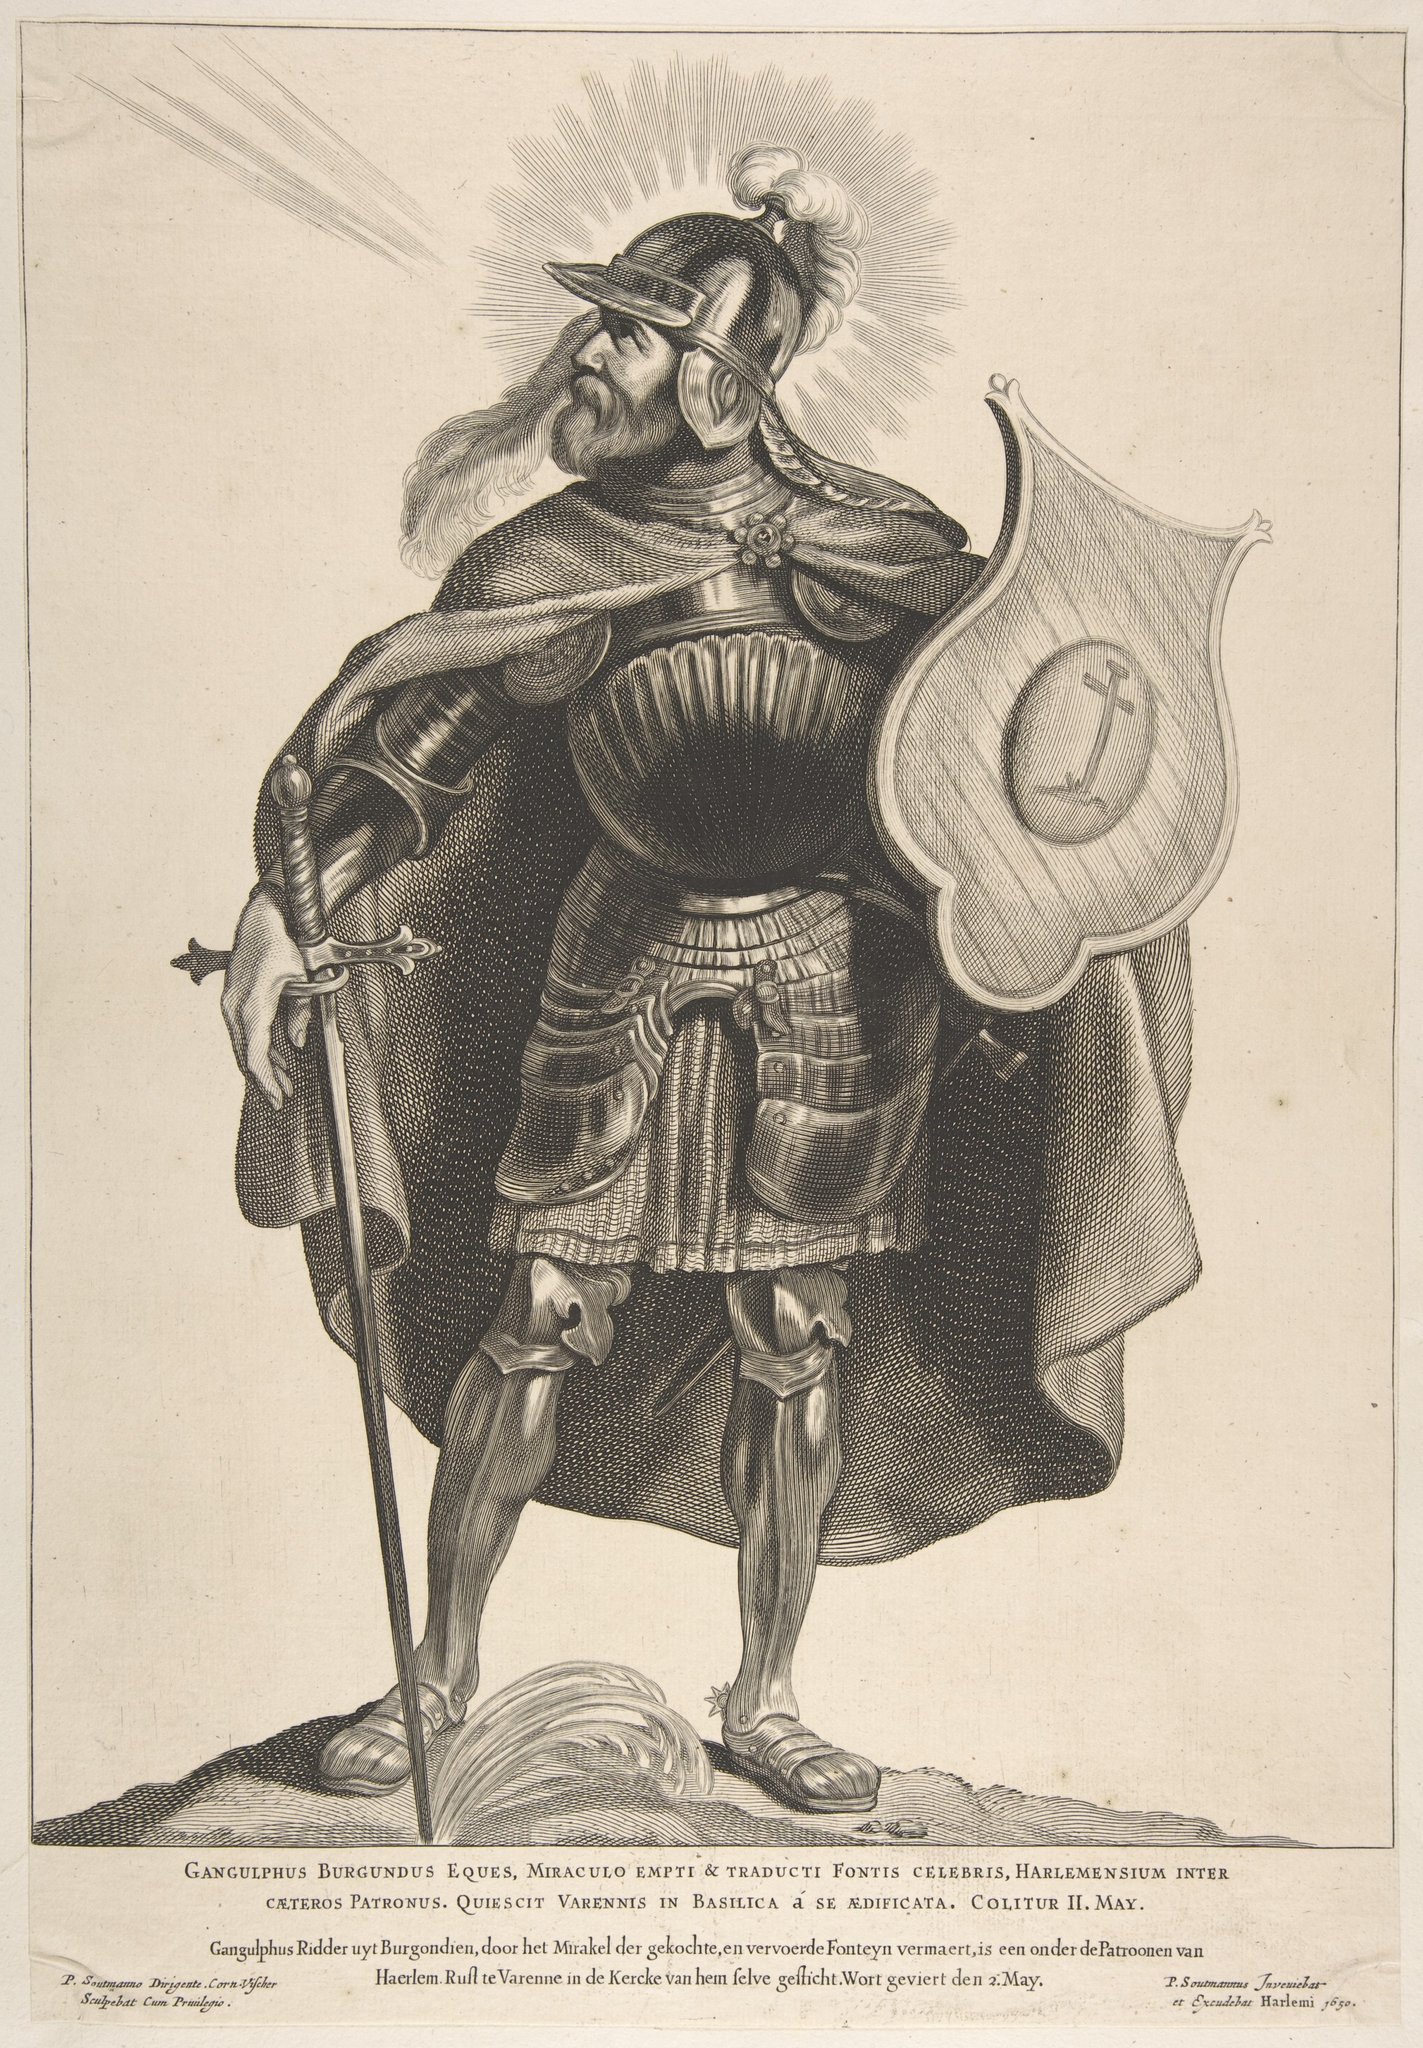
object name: print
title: St. Gangulphus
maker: cornelis visscher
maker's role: artist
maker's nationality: dutch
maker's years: 1628-1658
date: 1650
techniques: engraving, etching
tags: soldiers,shields,swords